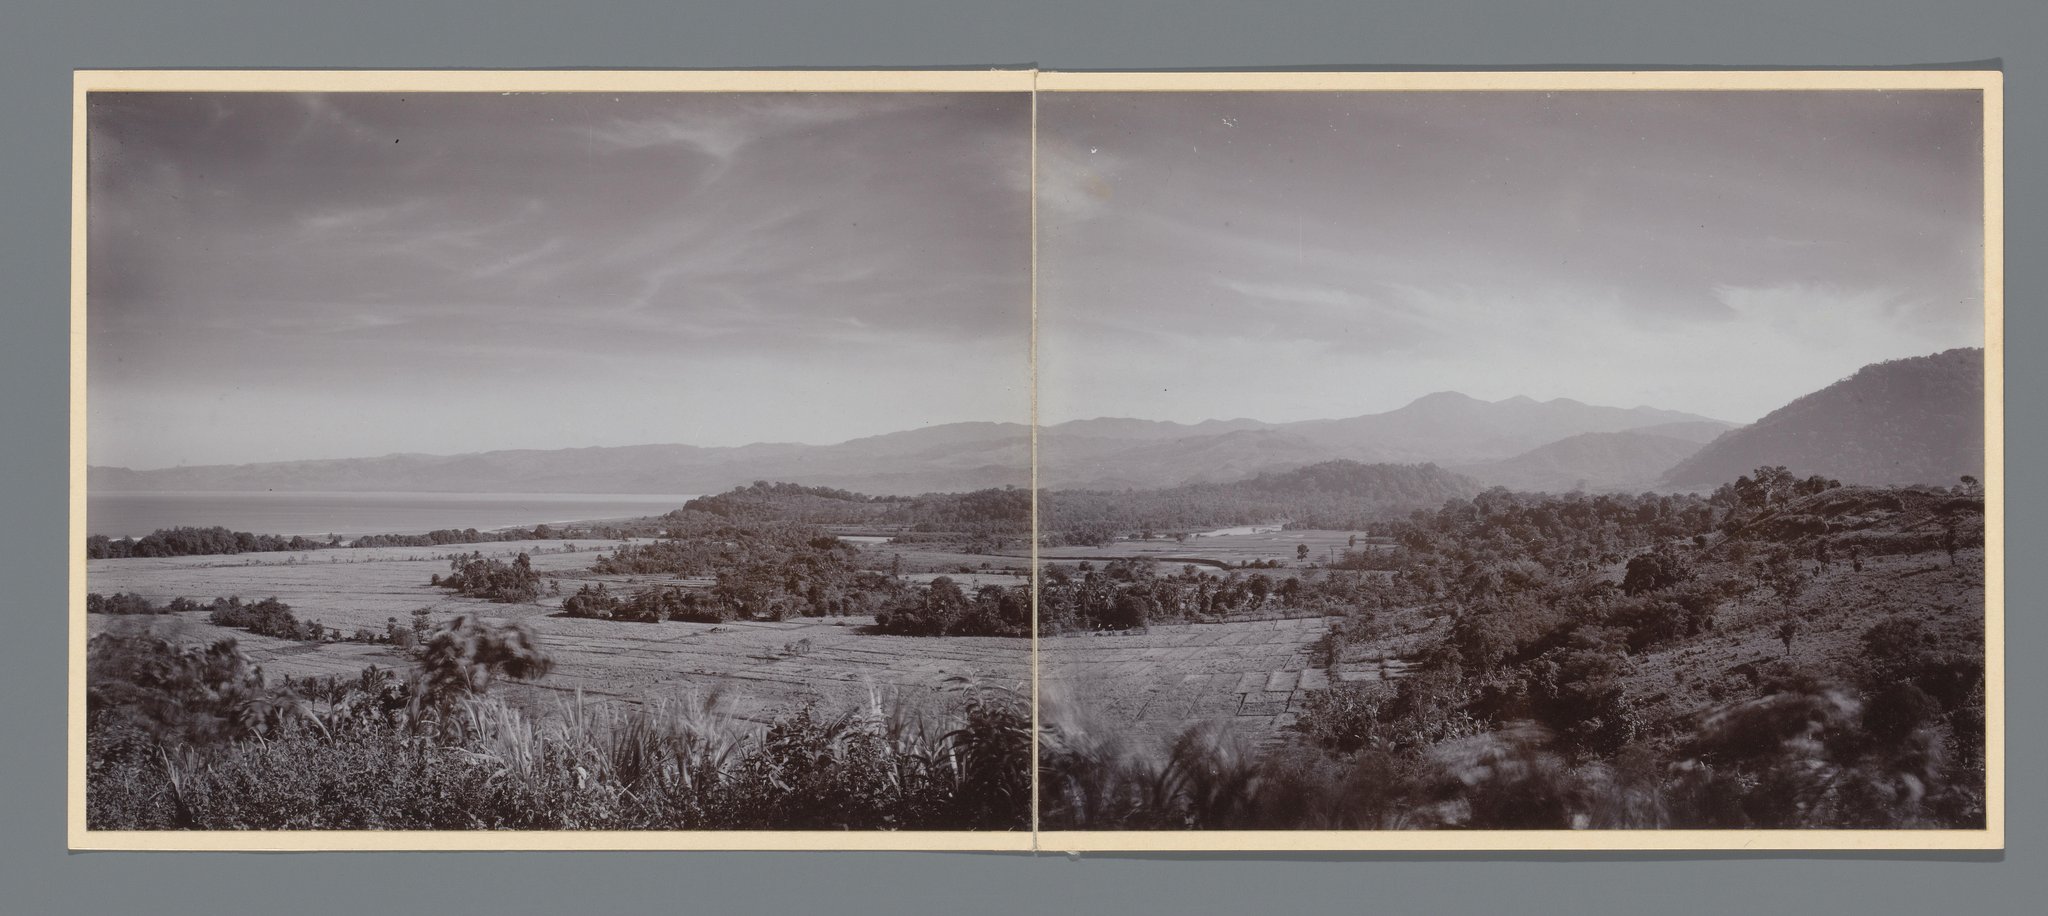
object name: photograph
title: Panorama van de Wijnkoopsbaai, Sumatra, panorama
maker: georg friedrich johannes bley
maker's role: fotograaf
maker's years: 1855-1944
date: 1870-1944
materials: cardboard, photographic support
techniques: collodion silver print, pasting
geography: sumatra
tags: sumatra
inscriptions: inscription: ‘Wijnkoopsbaai. Panorama gezien naar koopal Tjidadap in weg naar Djampang’, name: ‘phot. G.F.F. Bley’